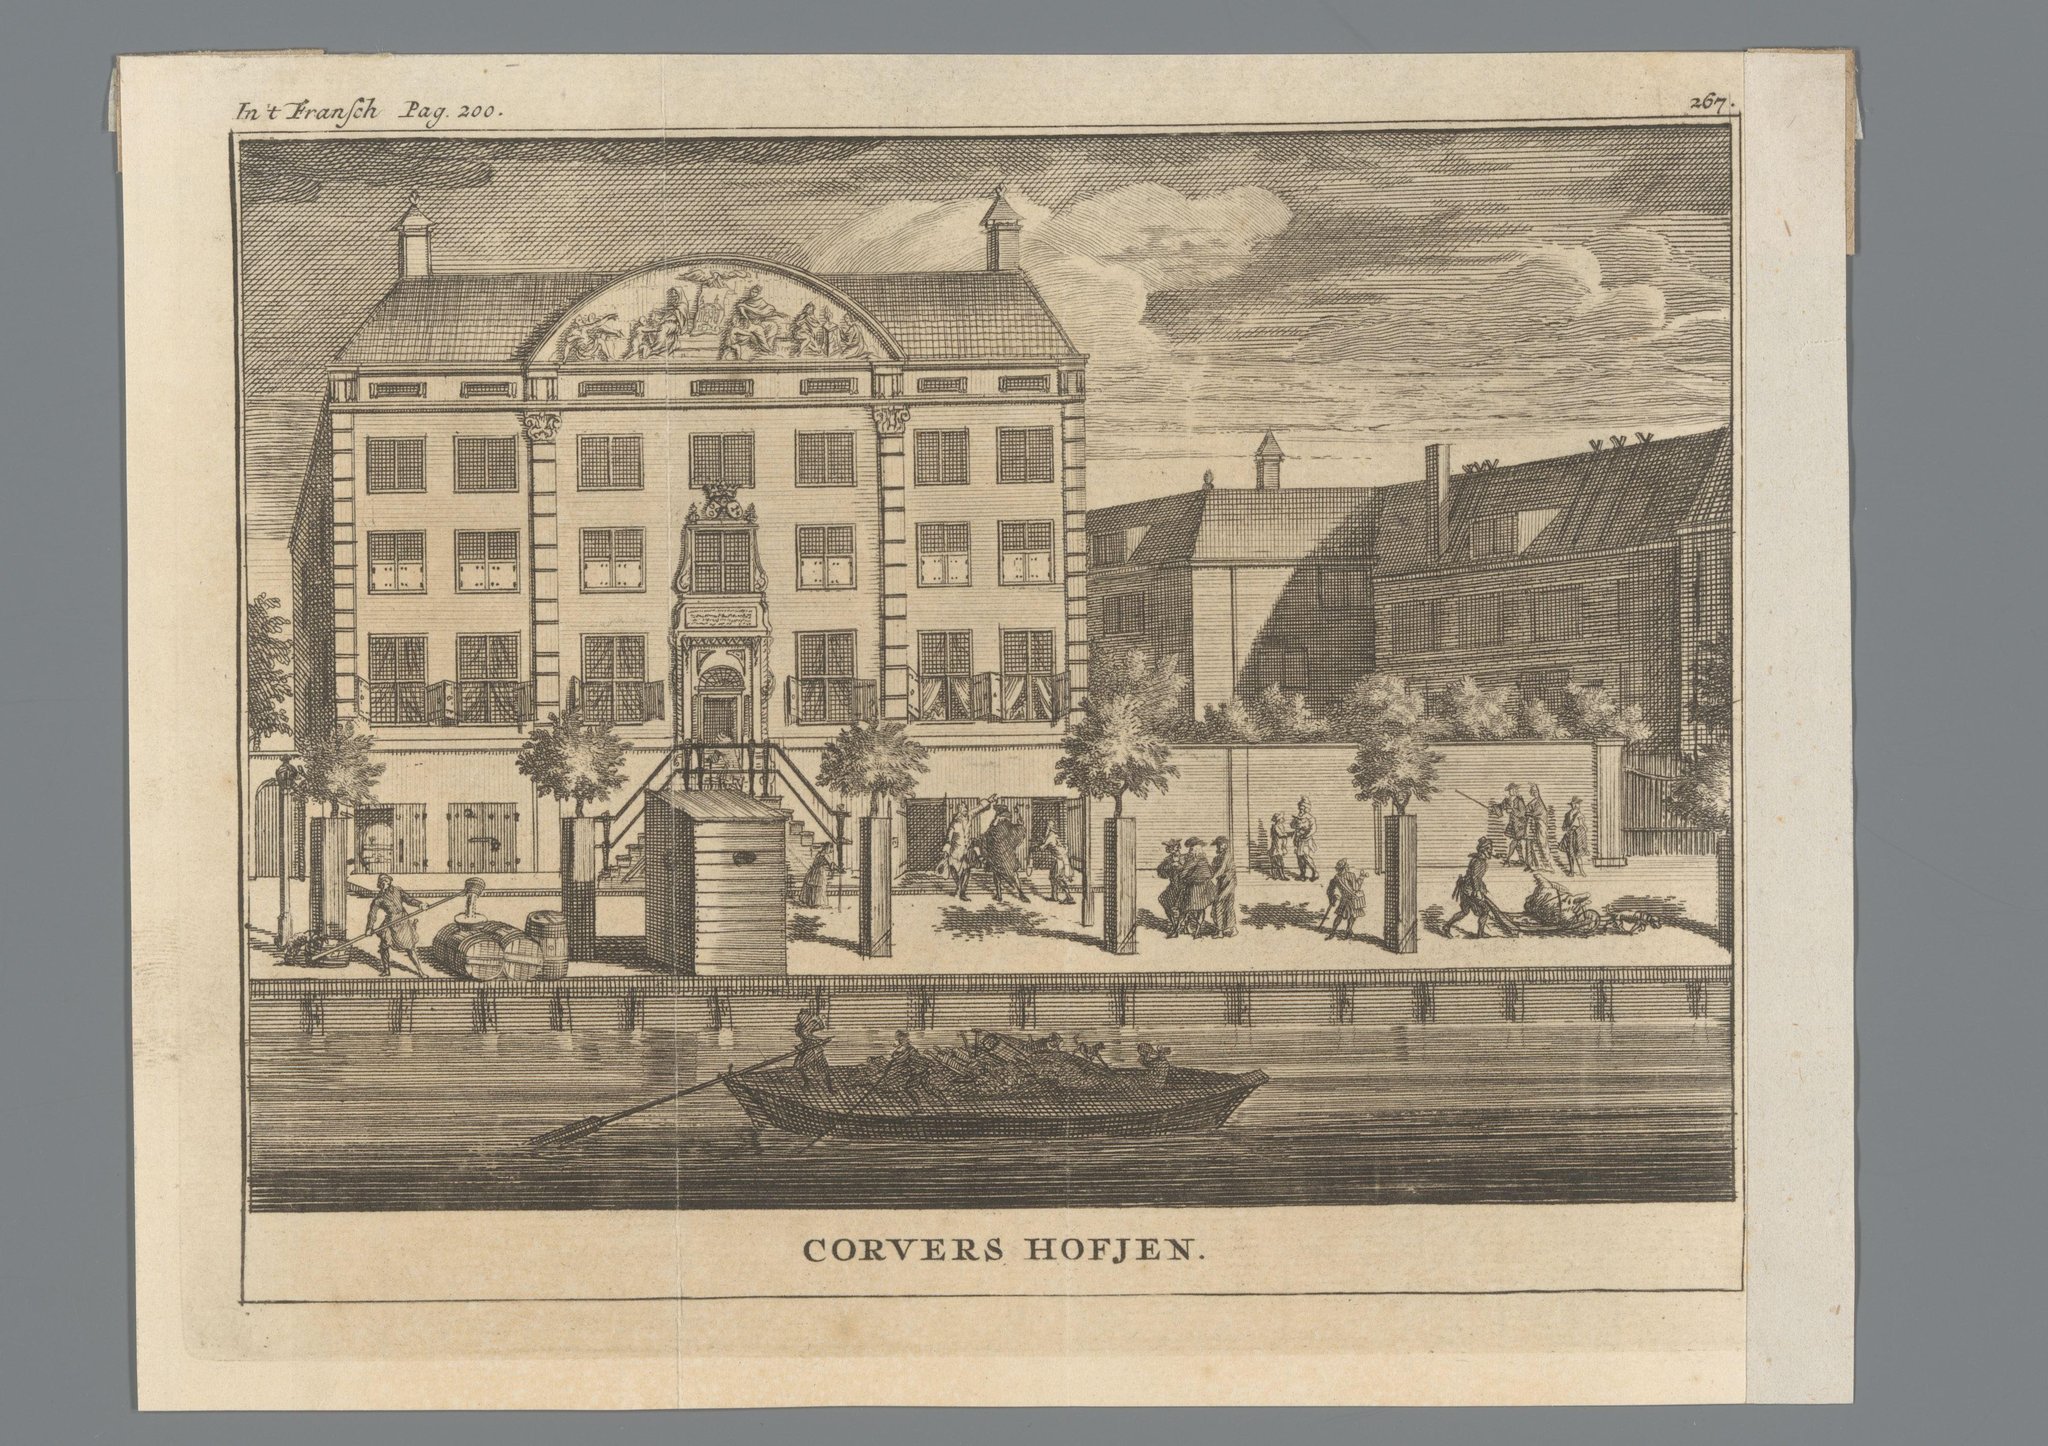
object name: print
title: Corvers Hofjen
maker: Anonymous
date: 1737-1751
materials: paper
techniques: engraving, etching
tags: public welfare, canals, waters (in city) (+ city(-scape) with figures, staffage), old-people's home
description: Prent mogelijk uit: Hoorn, Nicolaas ten. Wegwyzer, of korte beschryvinge van de stadt Amsterdam, zynde eene beknopte verhandeling van desselfs eerste opkomst, vergrootingen, en teegenwoordigen staat (...). Amsterdam: erven J. Ratelband & Co, 1737. Of uit: Hoorn, Nicolaas ten. Wegwyzer of korte beschryvinge der stad Amsterdam, zynde eene beknopte verhandeling van derzelver eerste opkomst, vergrootingen, en tegenwoordigen staat (...). Amsterdam: Pieter Meyer, 1751.